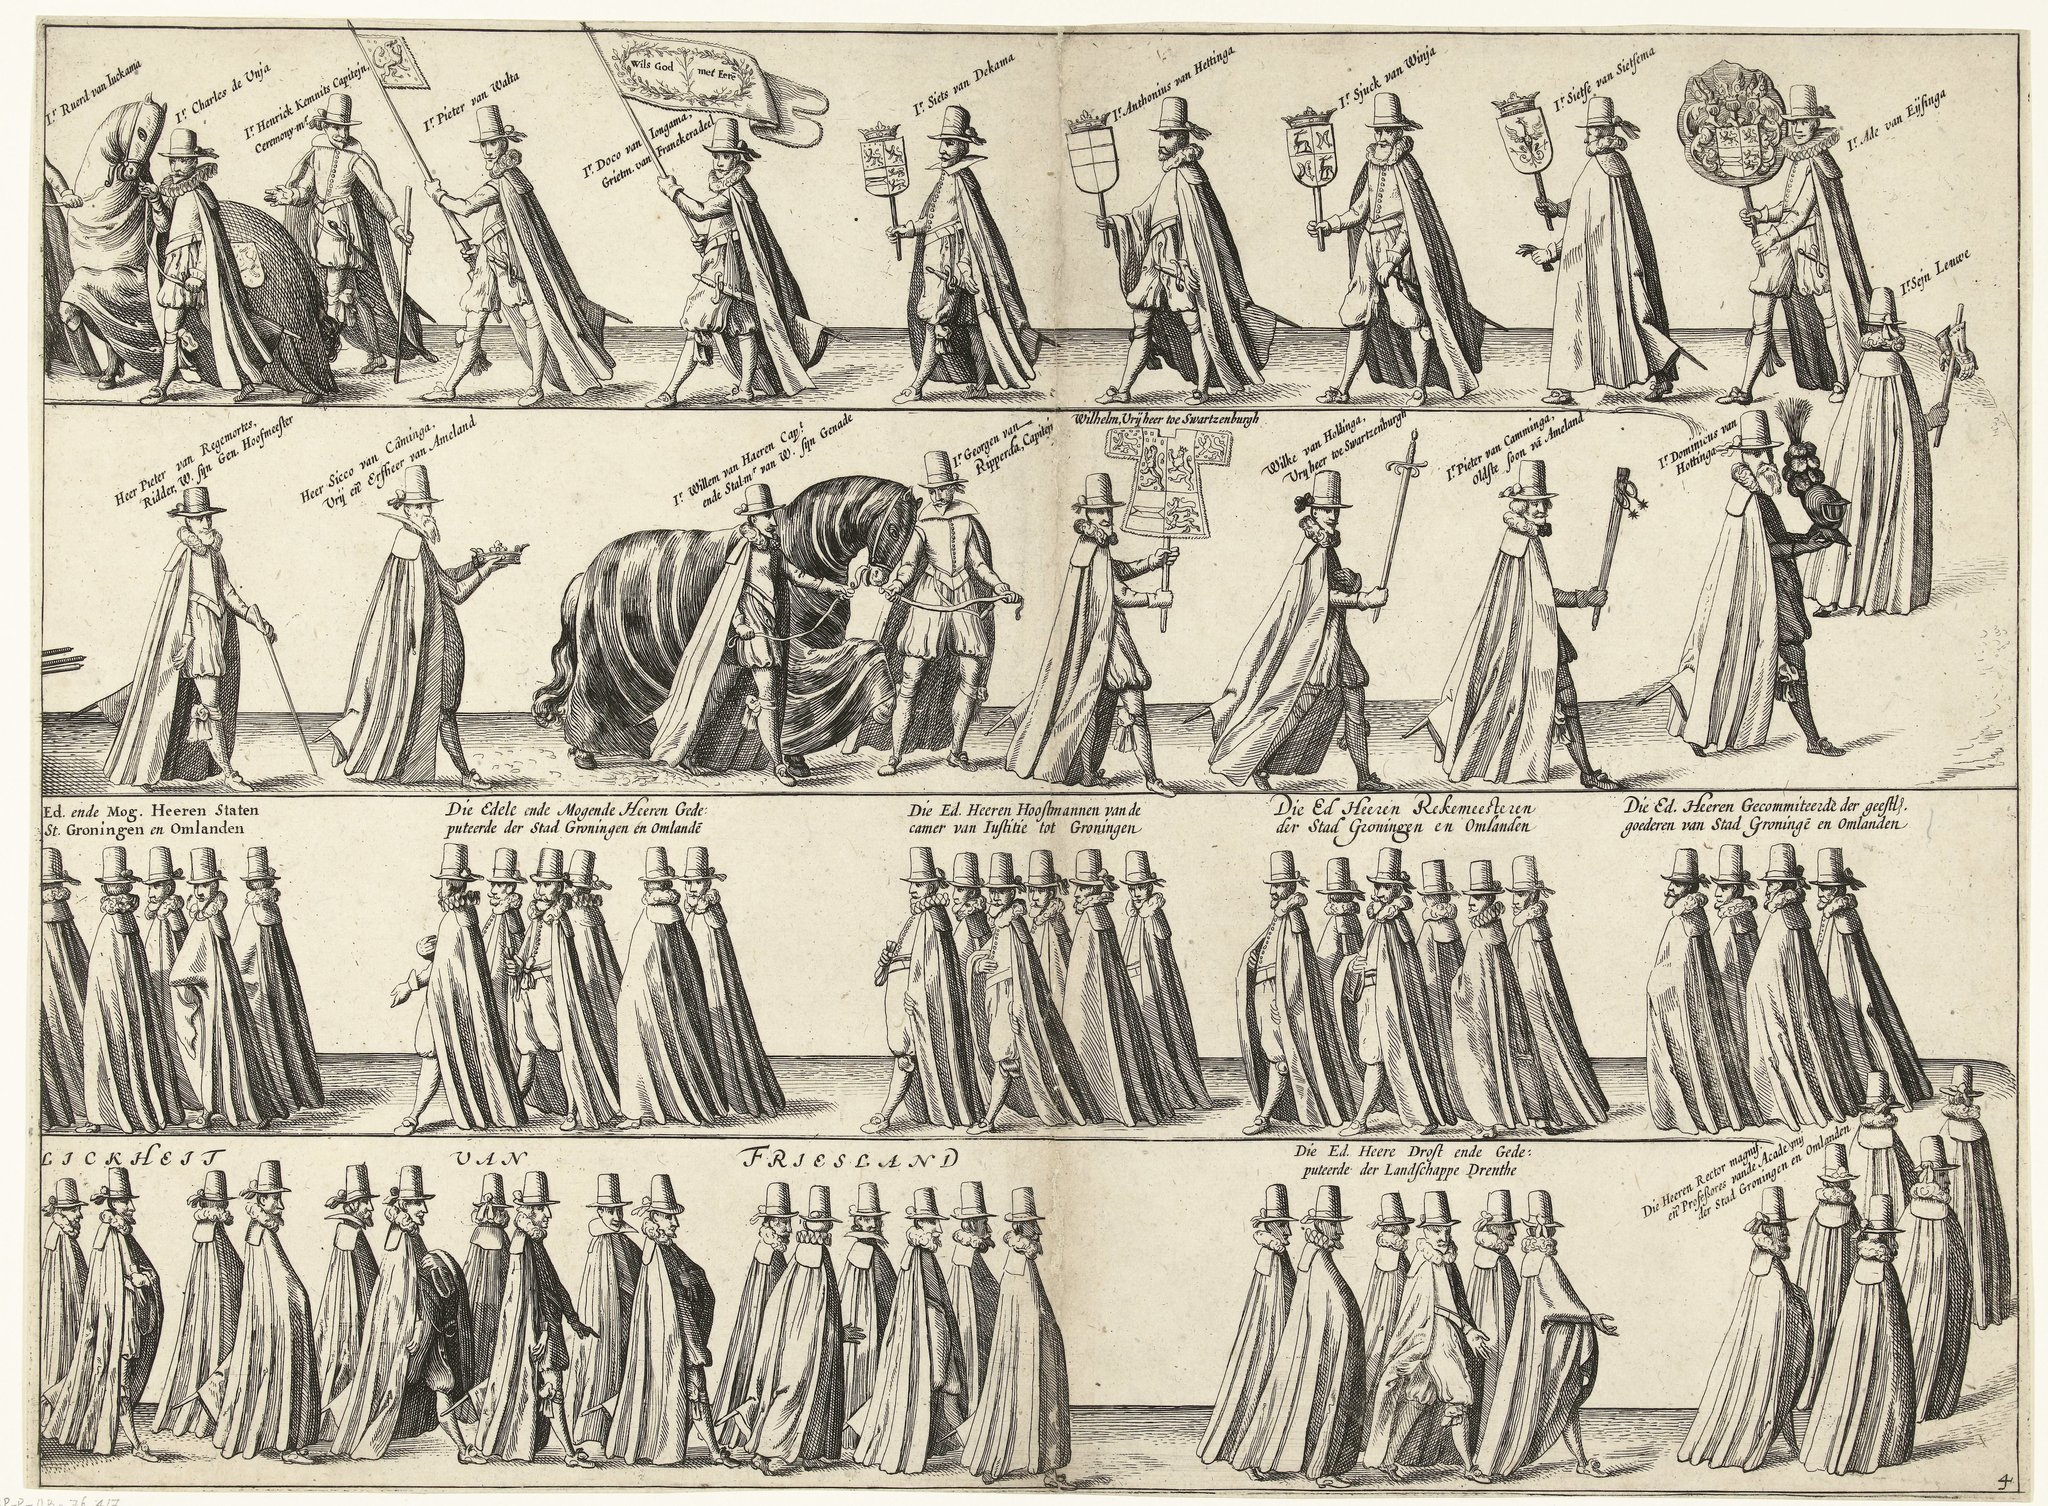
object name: print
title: Begrafenis van Willem Lodewijk, 1620 (blad 4)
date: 1620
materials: paper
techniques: etching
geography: northern netherlands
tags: willem lodewijk graaf van nassau-dillenburg, cortege, funeral procession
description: Begrafenis van Willem Lodewijk, graaf van Nassau, in de Grote Kerk te Leeuwarden op 13 juli 1620, blad 4. Blad met de eretekens, vaandels, wapens, paard etc. van graaf Willem Lodewijk gedragen door deelnemers aan de begrafenisstoet, met naam.